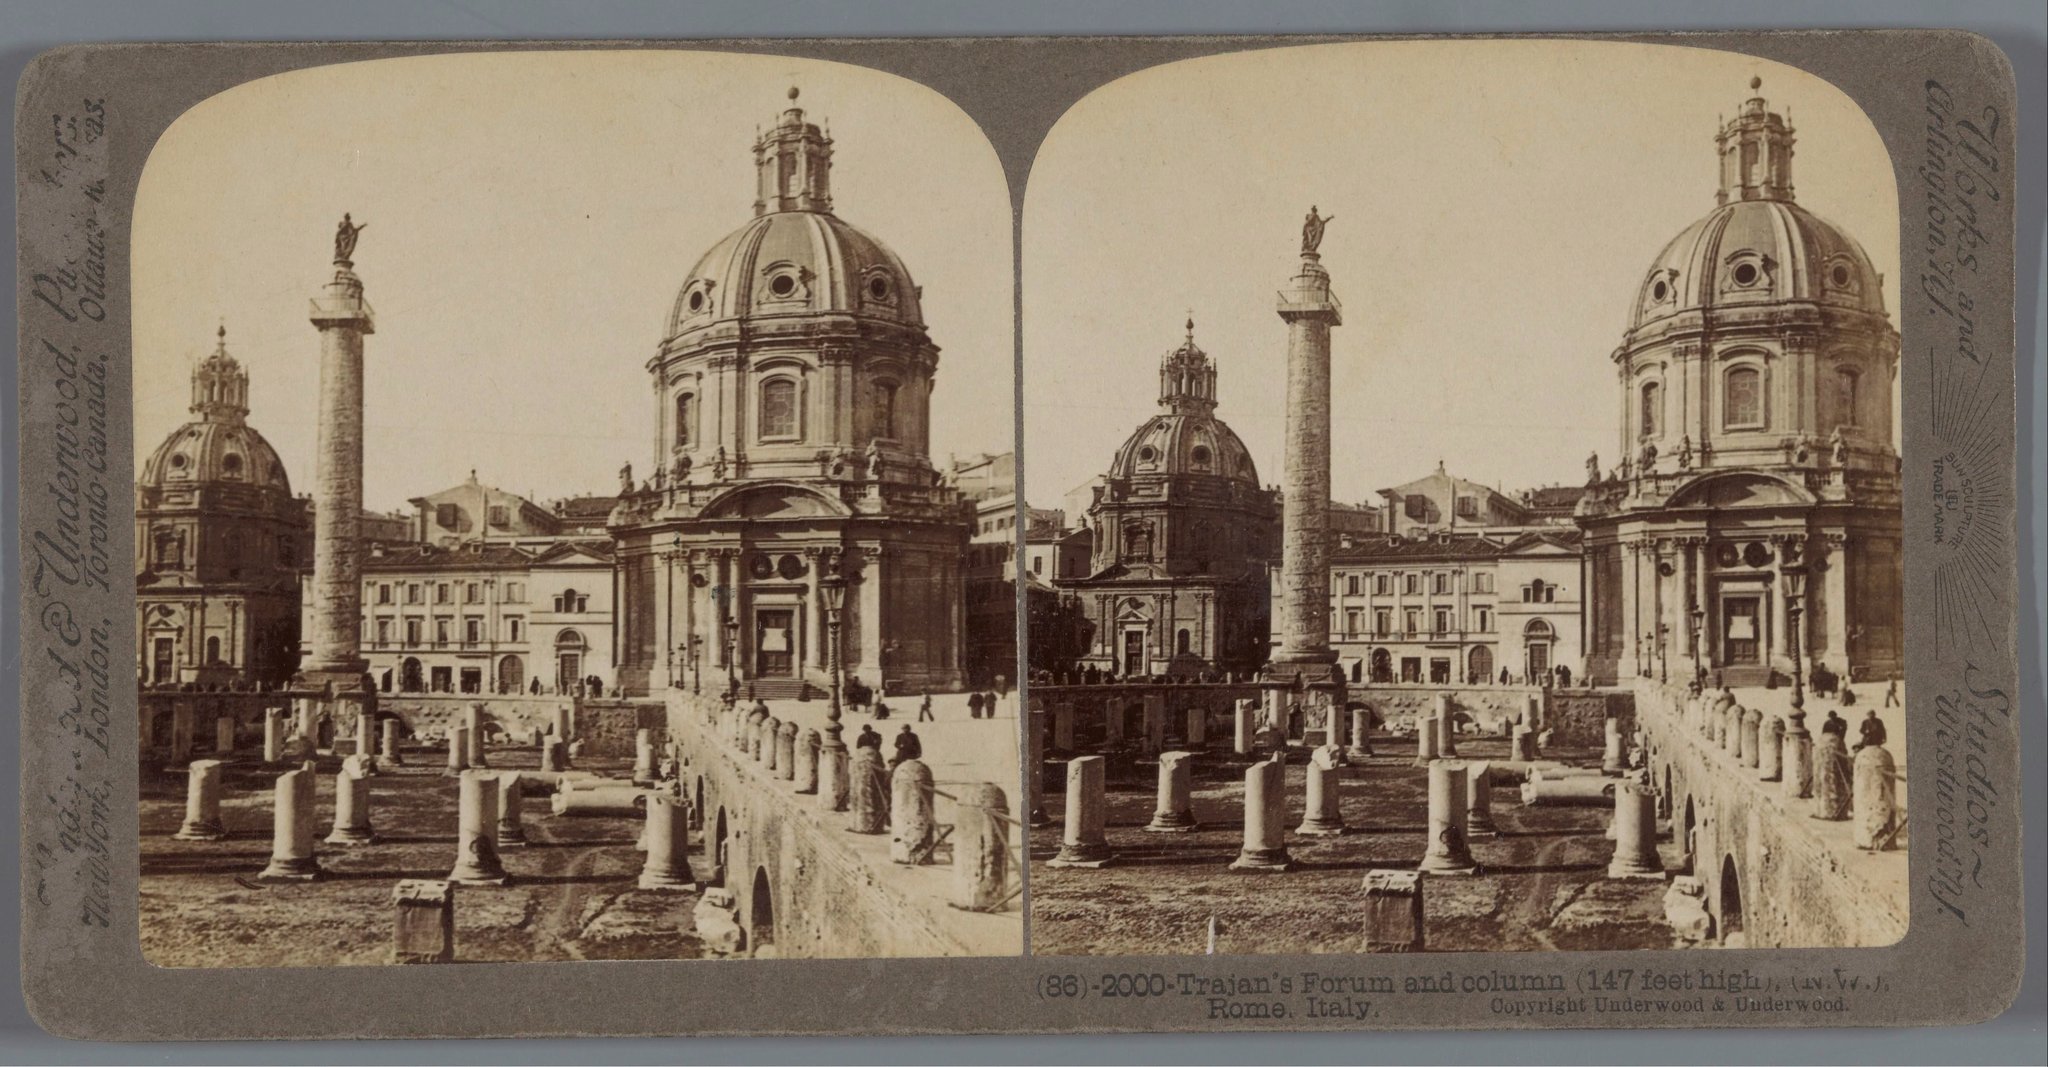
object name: stereograph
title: Forum van Trajanus te Rome, met op de achtergrond de Santa Maria di Loreto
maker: Anonymous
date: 1890-1910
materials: cardboard, photographic support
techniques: albumen print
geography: forum of trajan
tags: column, pillar ~ architecture, ruin of a building ~ architecture, church (exterior)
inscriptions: name: ‘Underwood & Underwood Publishers New York, London, Toronto-Canada, Ottawa-Kansas.’, inscription: ‘Works and Studios Arlington, N.J. Westwood, N.J. Washington, D.C.’, number: ‘(86)-2000’